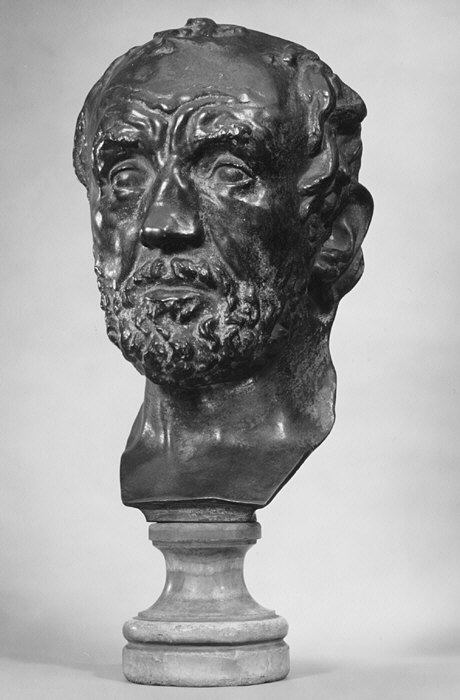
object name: bust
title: Mask of the Man with the Broken Nose (Masque de l'homme au nez cassé)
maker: auguste rodin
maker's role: artist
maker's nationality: french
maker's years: 1840-1917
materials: bronze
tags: men